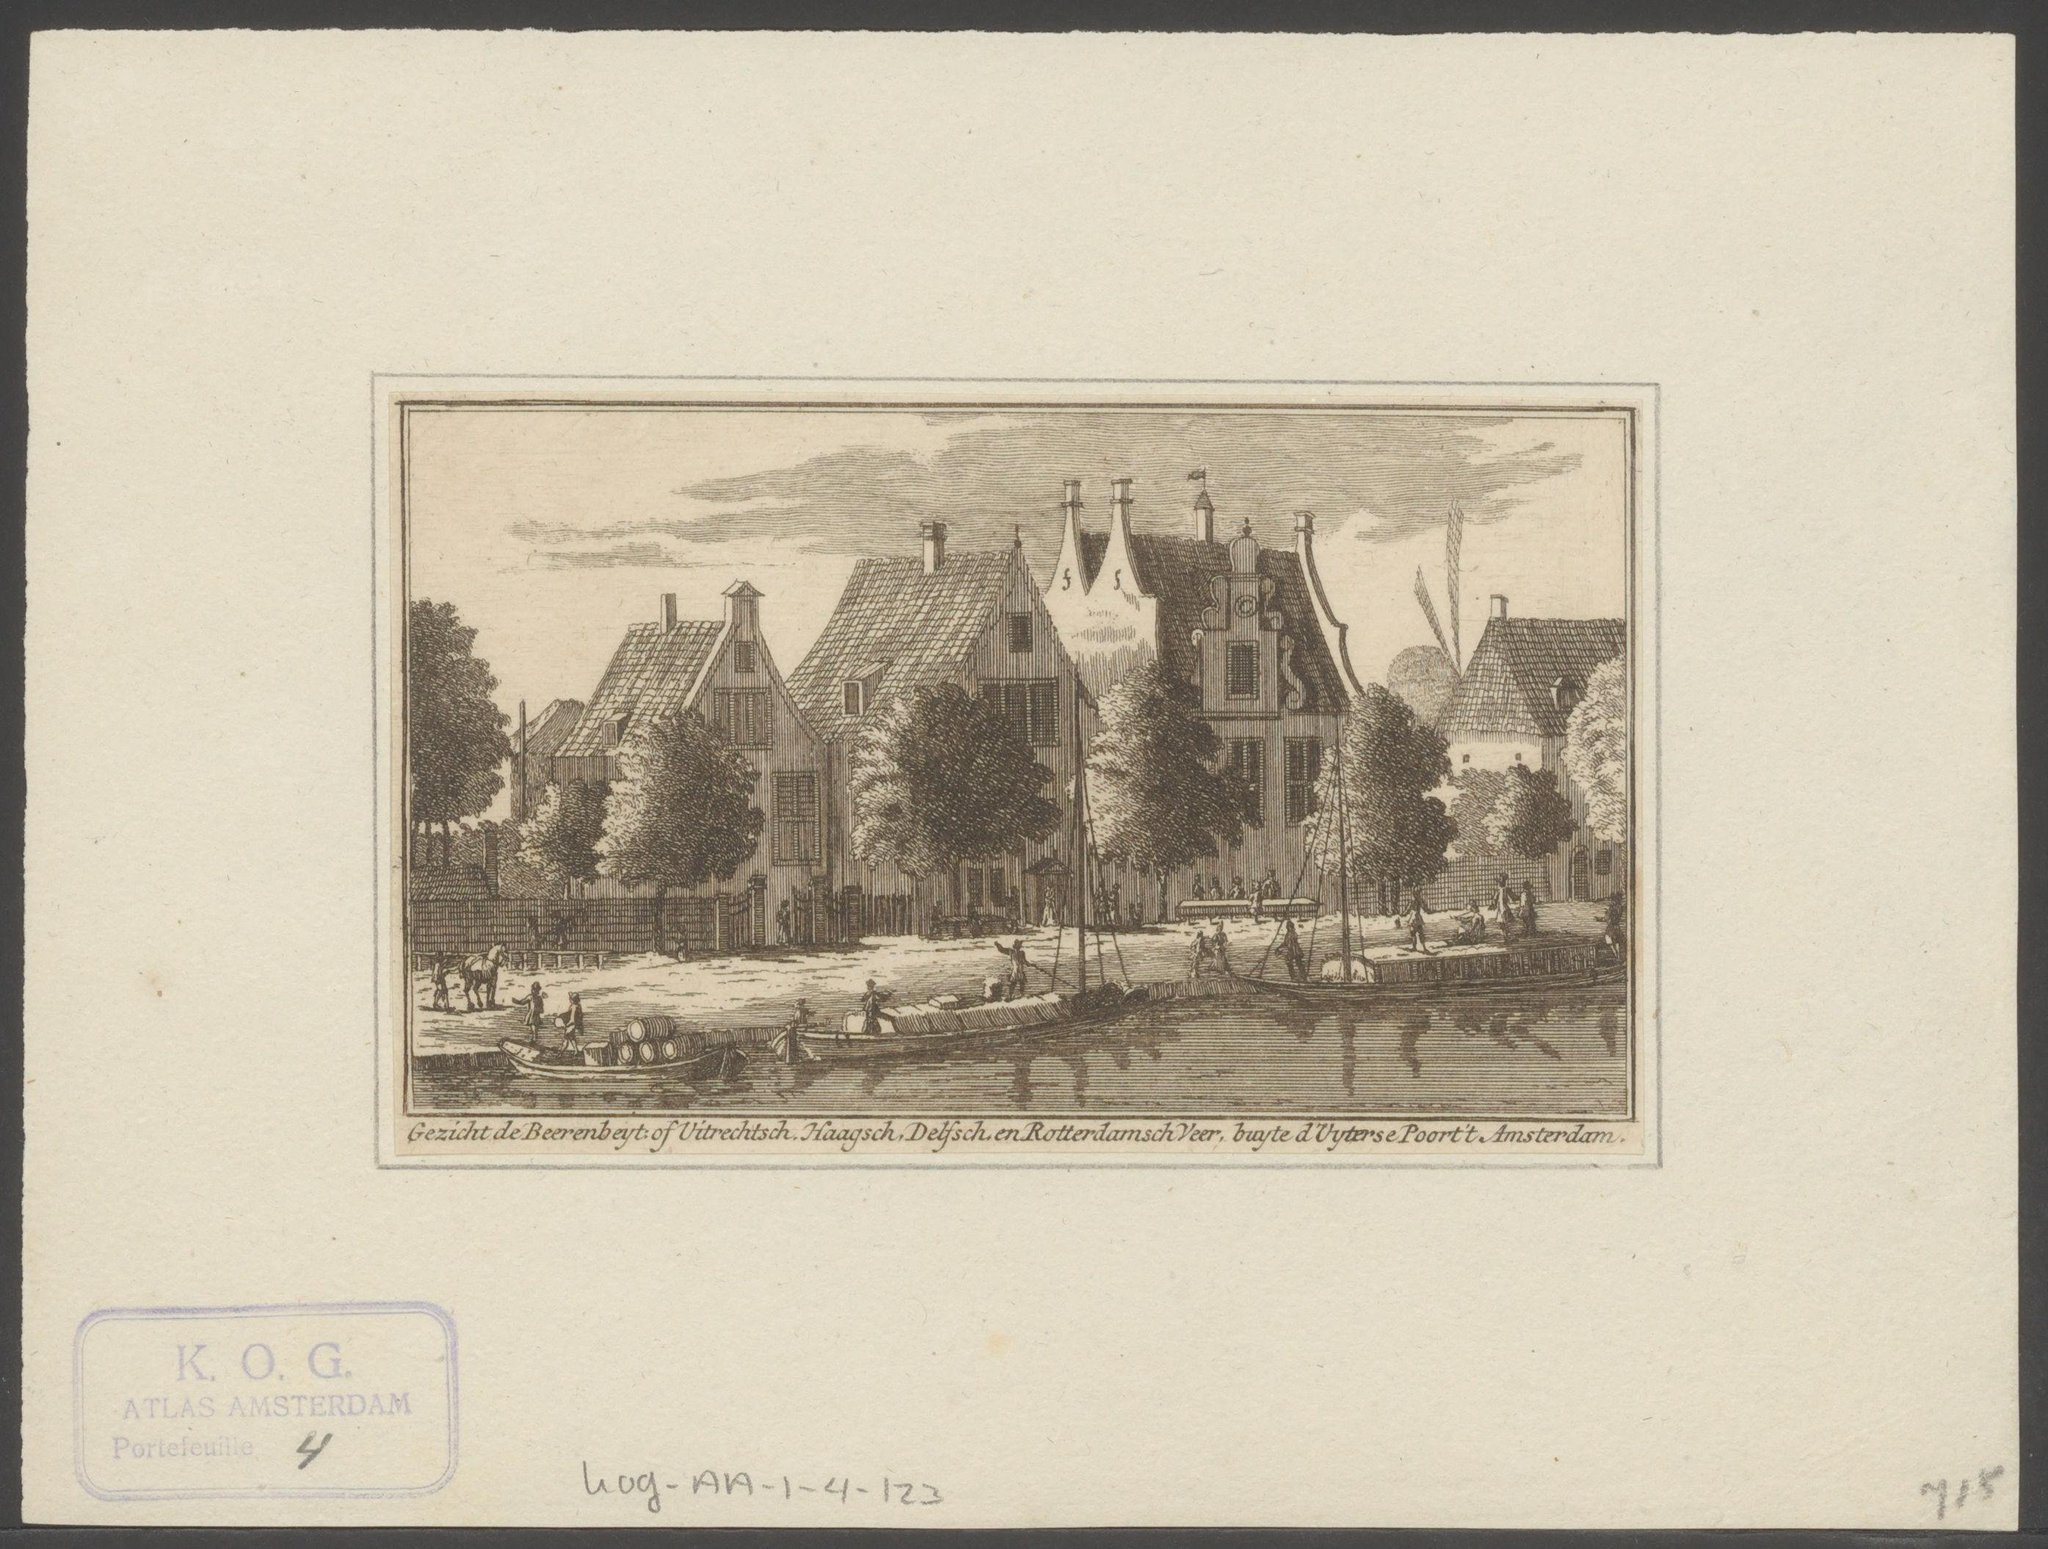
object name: print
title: Gezicht op een herberg aan de Amstel buiten de Utrechtsepoort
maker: Anonymous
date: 1700-1750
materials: paper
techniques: etching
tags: city-view in general; 'veduta', river, inn, coffee-house, public house, etc., boat propelled by man or animal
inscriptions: collector's mark: ‘4’ Lugt 1641b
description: Onderwerpsrubriek binnen de Atlas Amsterdam: Amstel van Hogesluis stroomopwaarts.